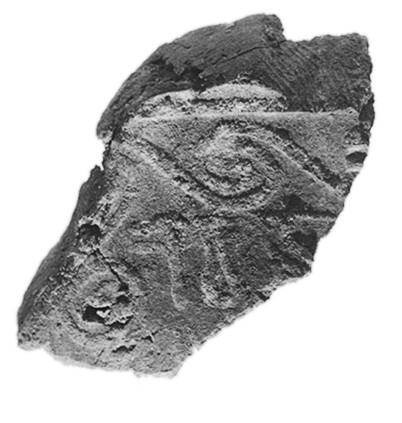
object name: sealing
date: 2030-1640 BCE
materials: clay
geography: egypt